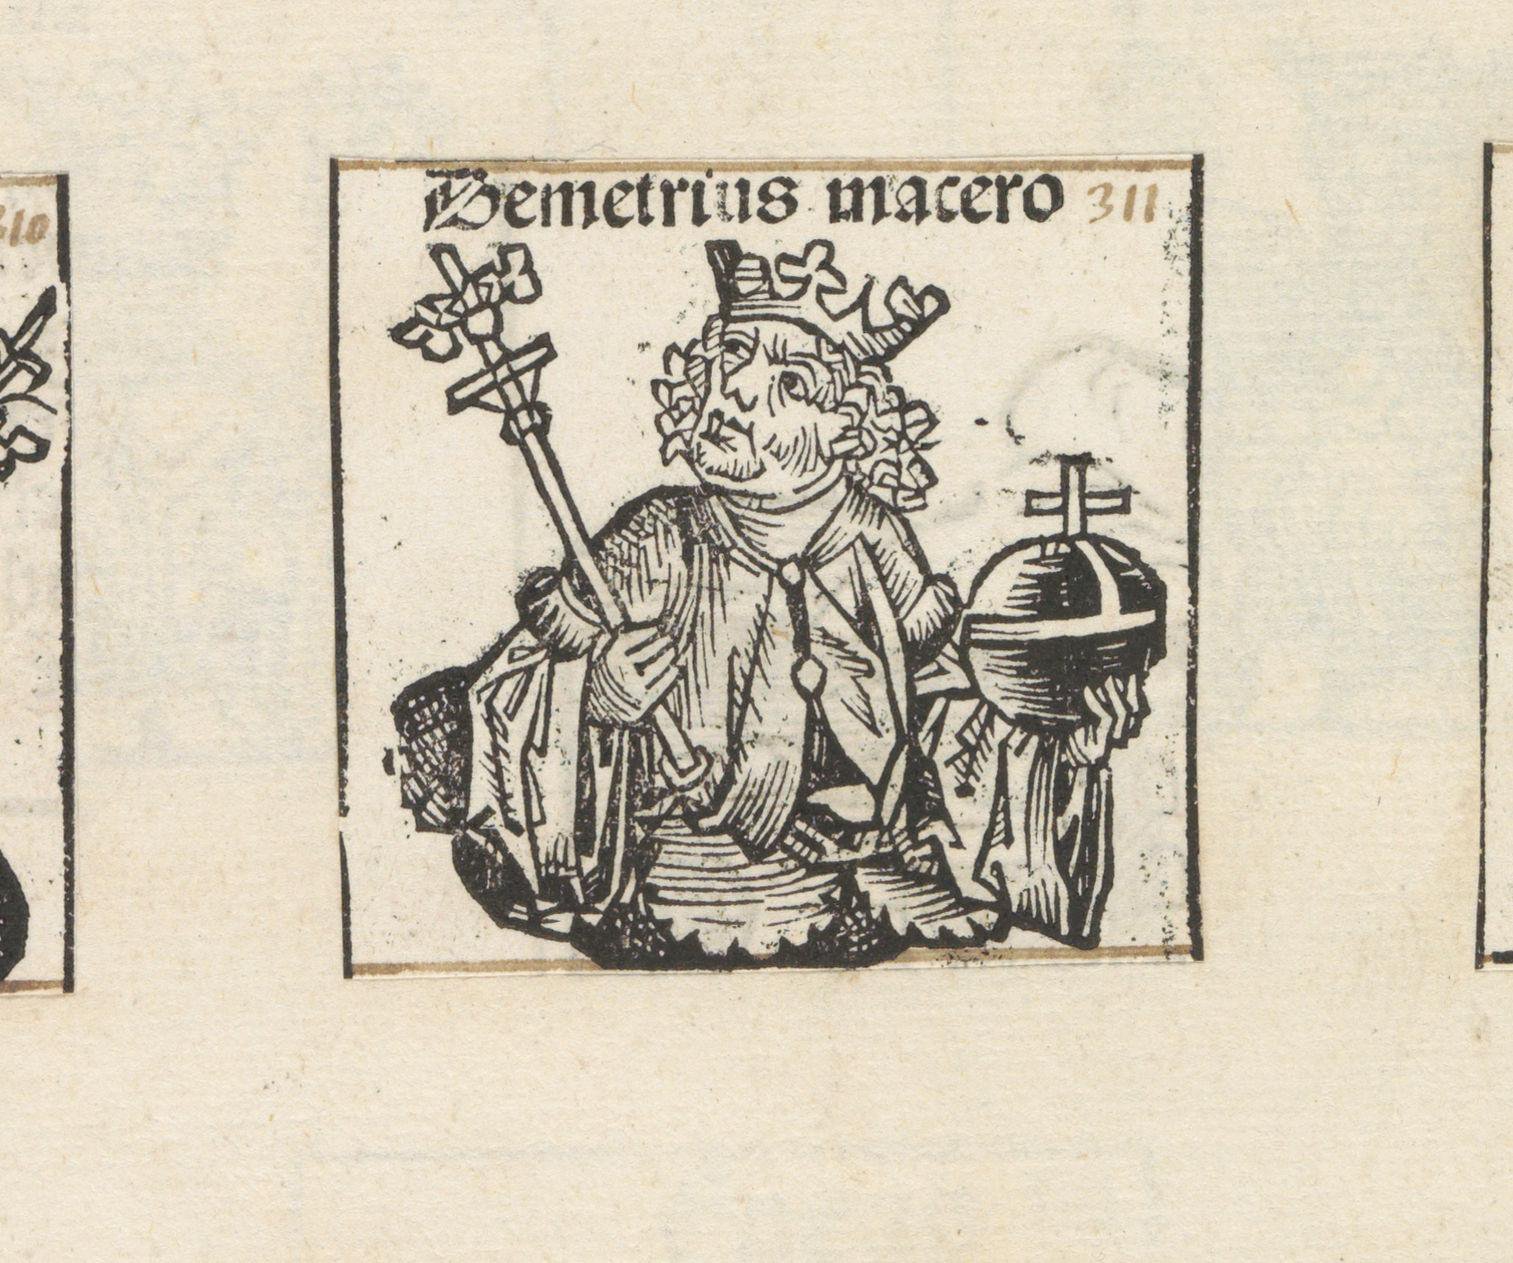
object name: album leaf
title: Koning Demetrius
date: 1493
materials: paper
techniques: letterpress printing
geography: nuremberg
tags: king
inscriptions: inscription: ‘311’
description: Een bloemkelk met een koning, zijn hoofd naar links gekeerd. De man heeft een rijksappel en een scepter in zijn handen. De voorstelling is onderdeel van de opeenvolging Syrische koningen in de Liber Chronicarum. De tekst identificeert hem als Demetrius. Mogelijk betreft het Demetrius II Nicator. De prent maakt deel uit van een album.